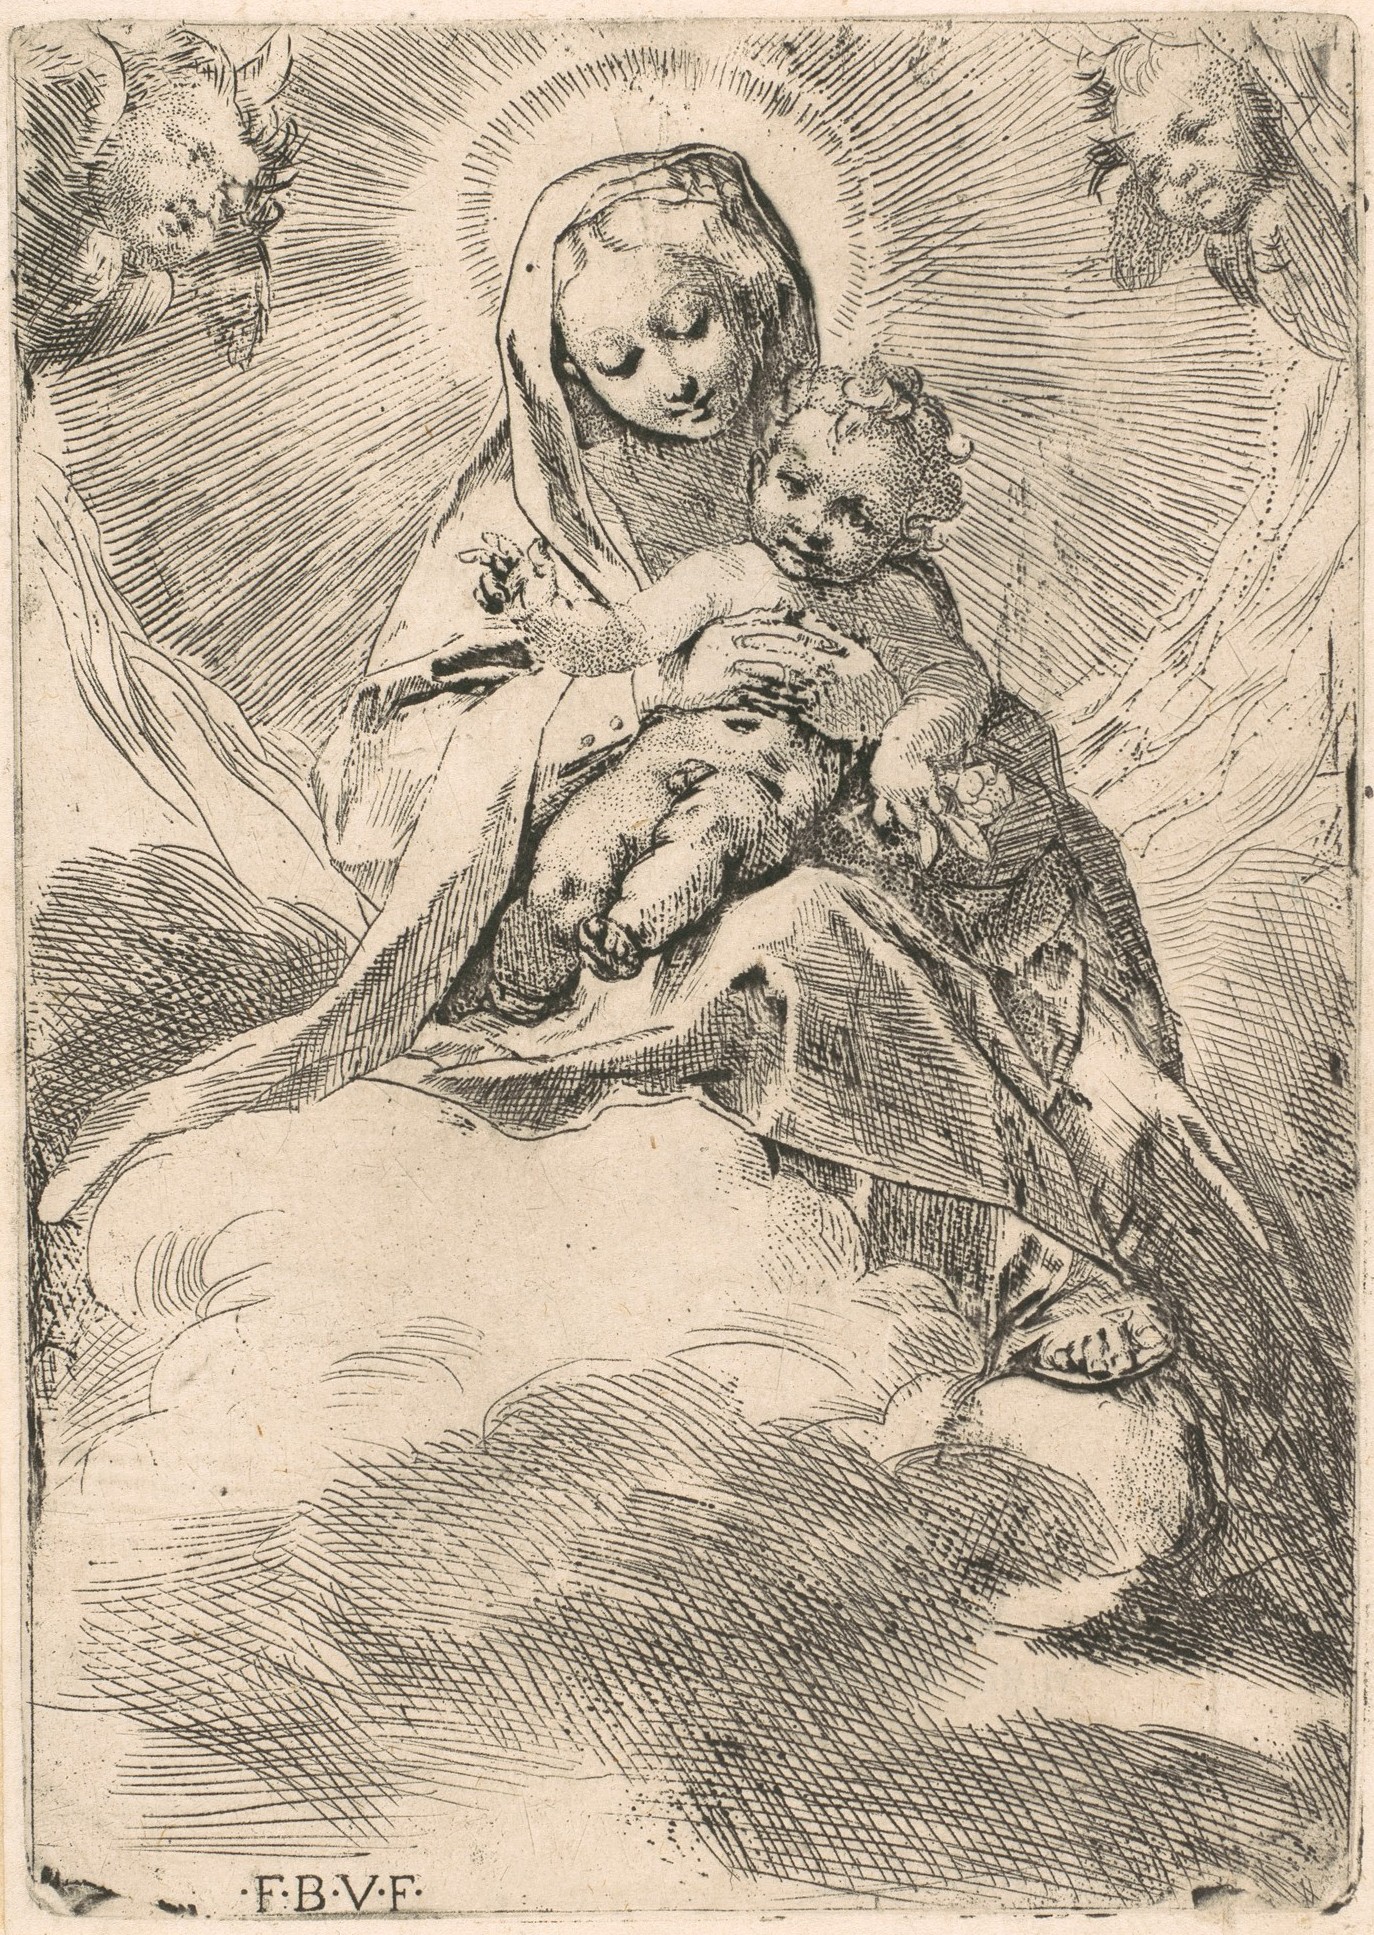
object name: print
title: The Virgin seated on a cloud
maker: federico barocci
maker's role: artist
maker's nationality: italian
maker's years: 1535-1612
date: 1580-1584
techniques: engraving, etching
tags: madonna and child